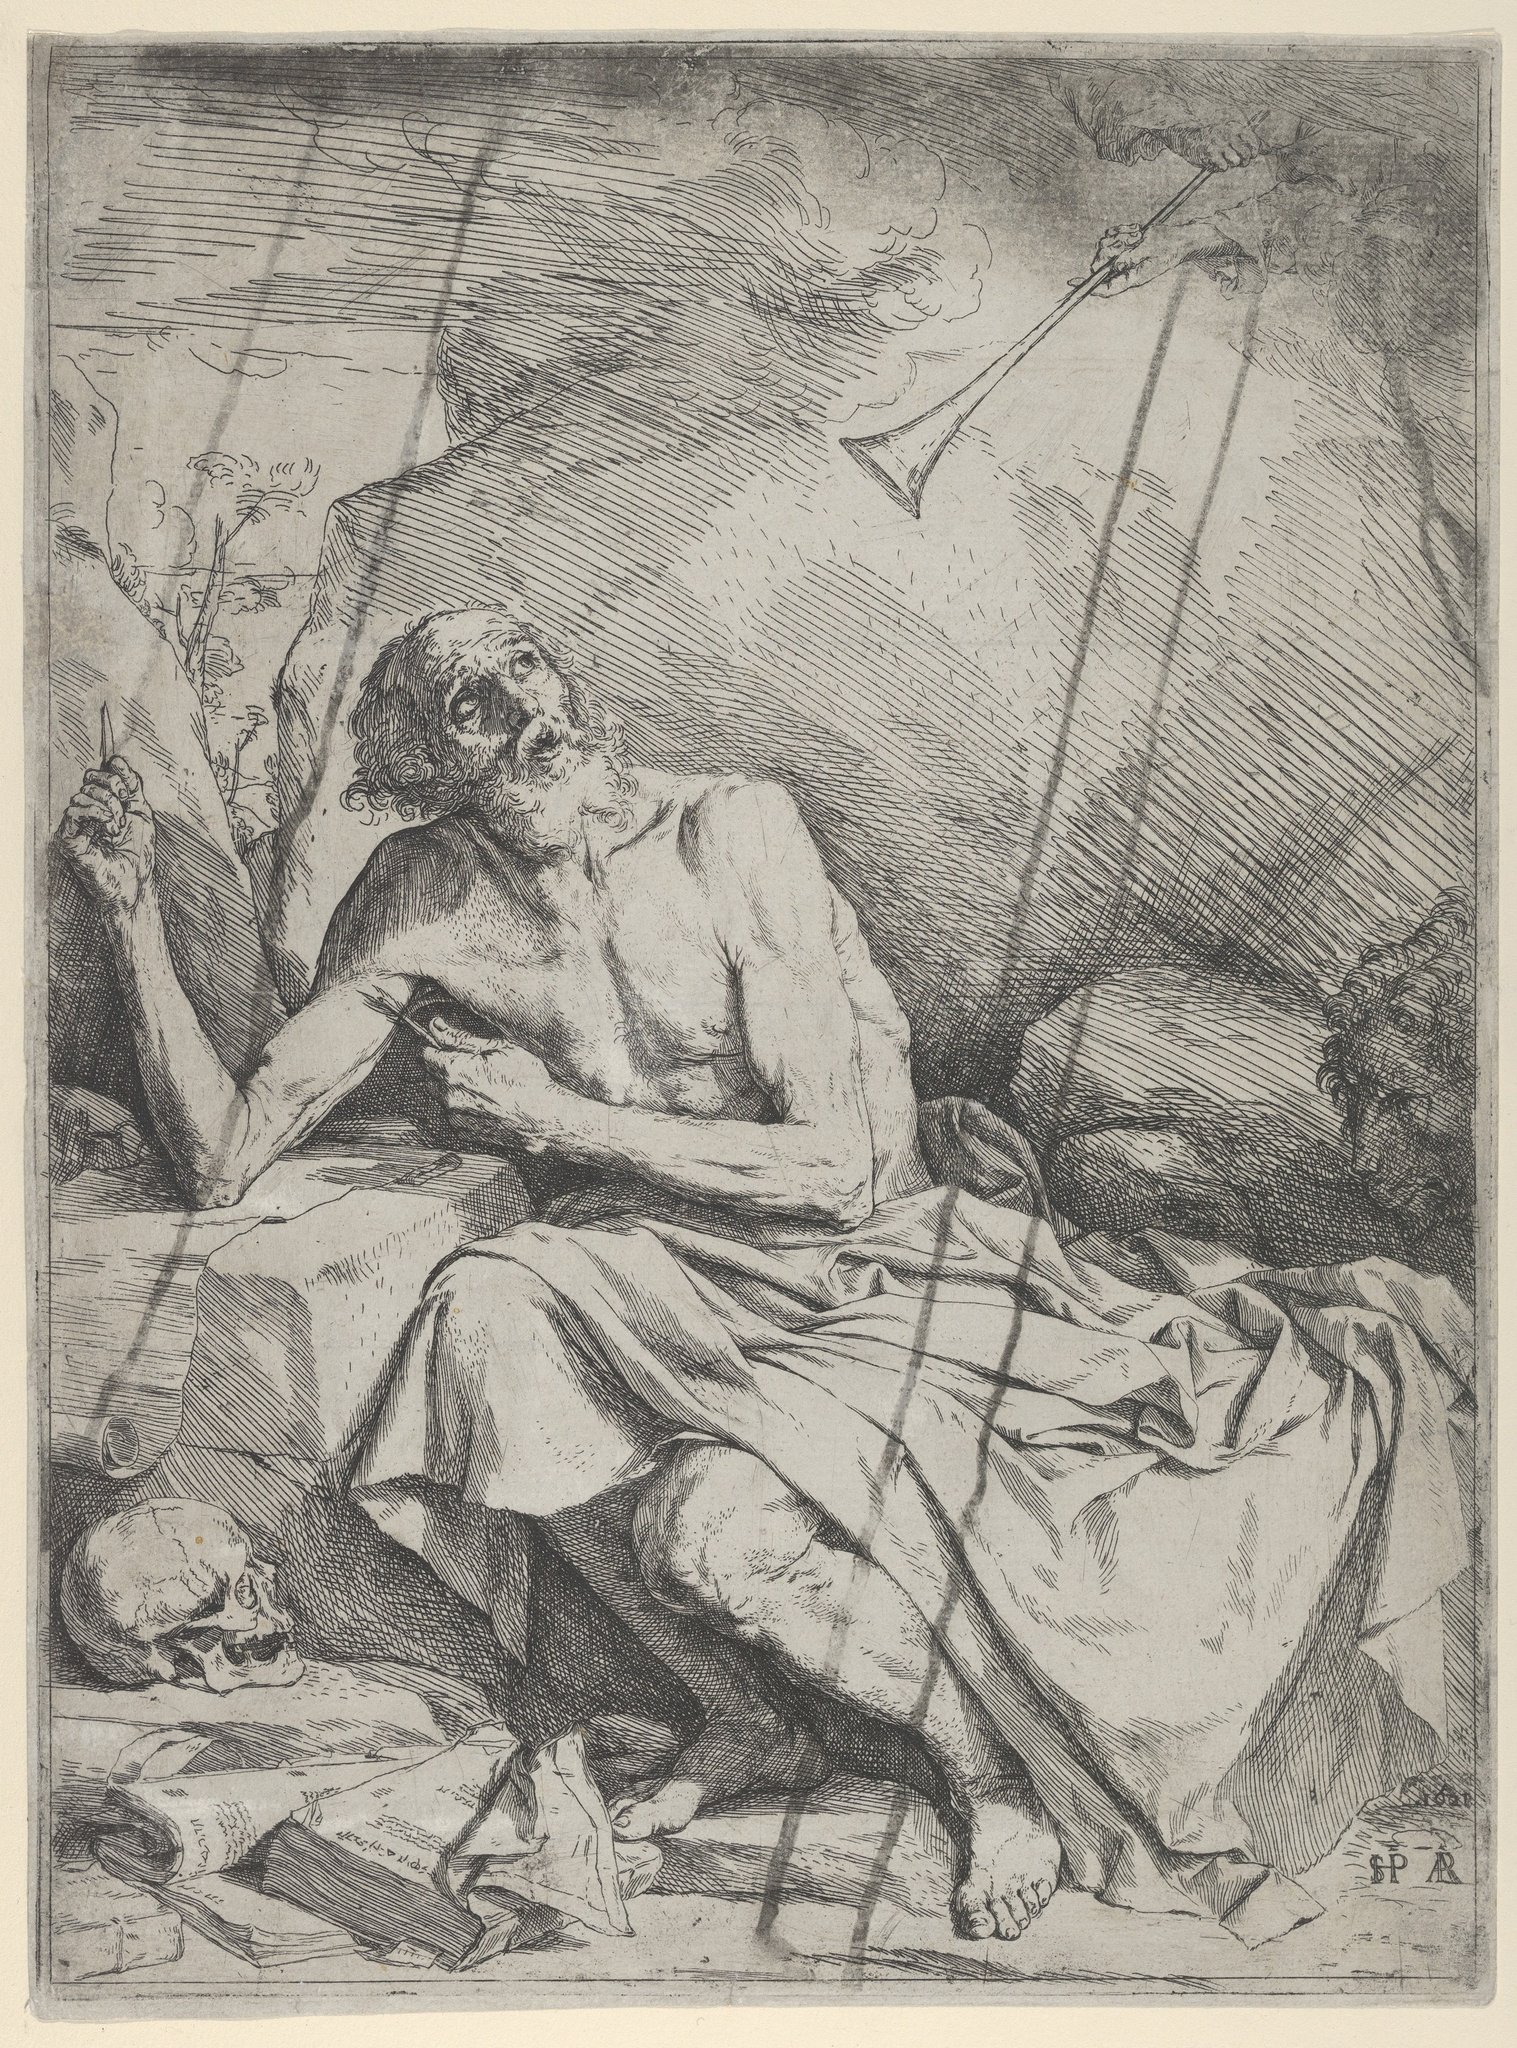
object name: print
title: Saint Jerome Hearing the Trumpet of the Last Judgment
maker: jusepe de ribera (called lo spagnoletto)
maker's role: artist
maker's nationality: spanish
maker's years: 1591-1652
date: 1621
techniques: drypoint, engraving, etching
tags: skulls,men,trumpets,saint jerome